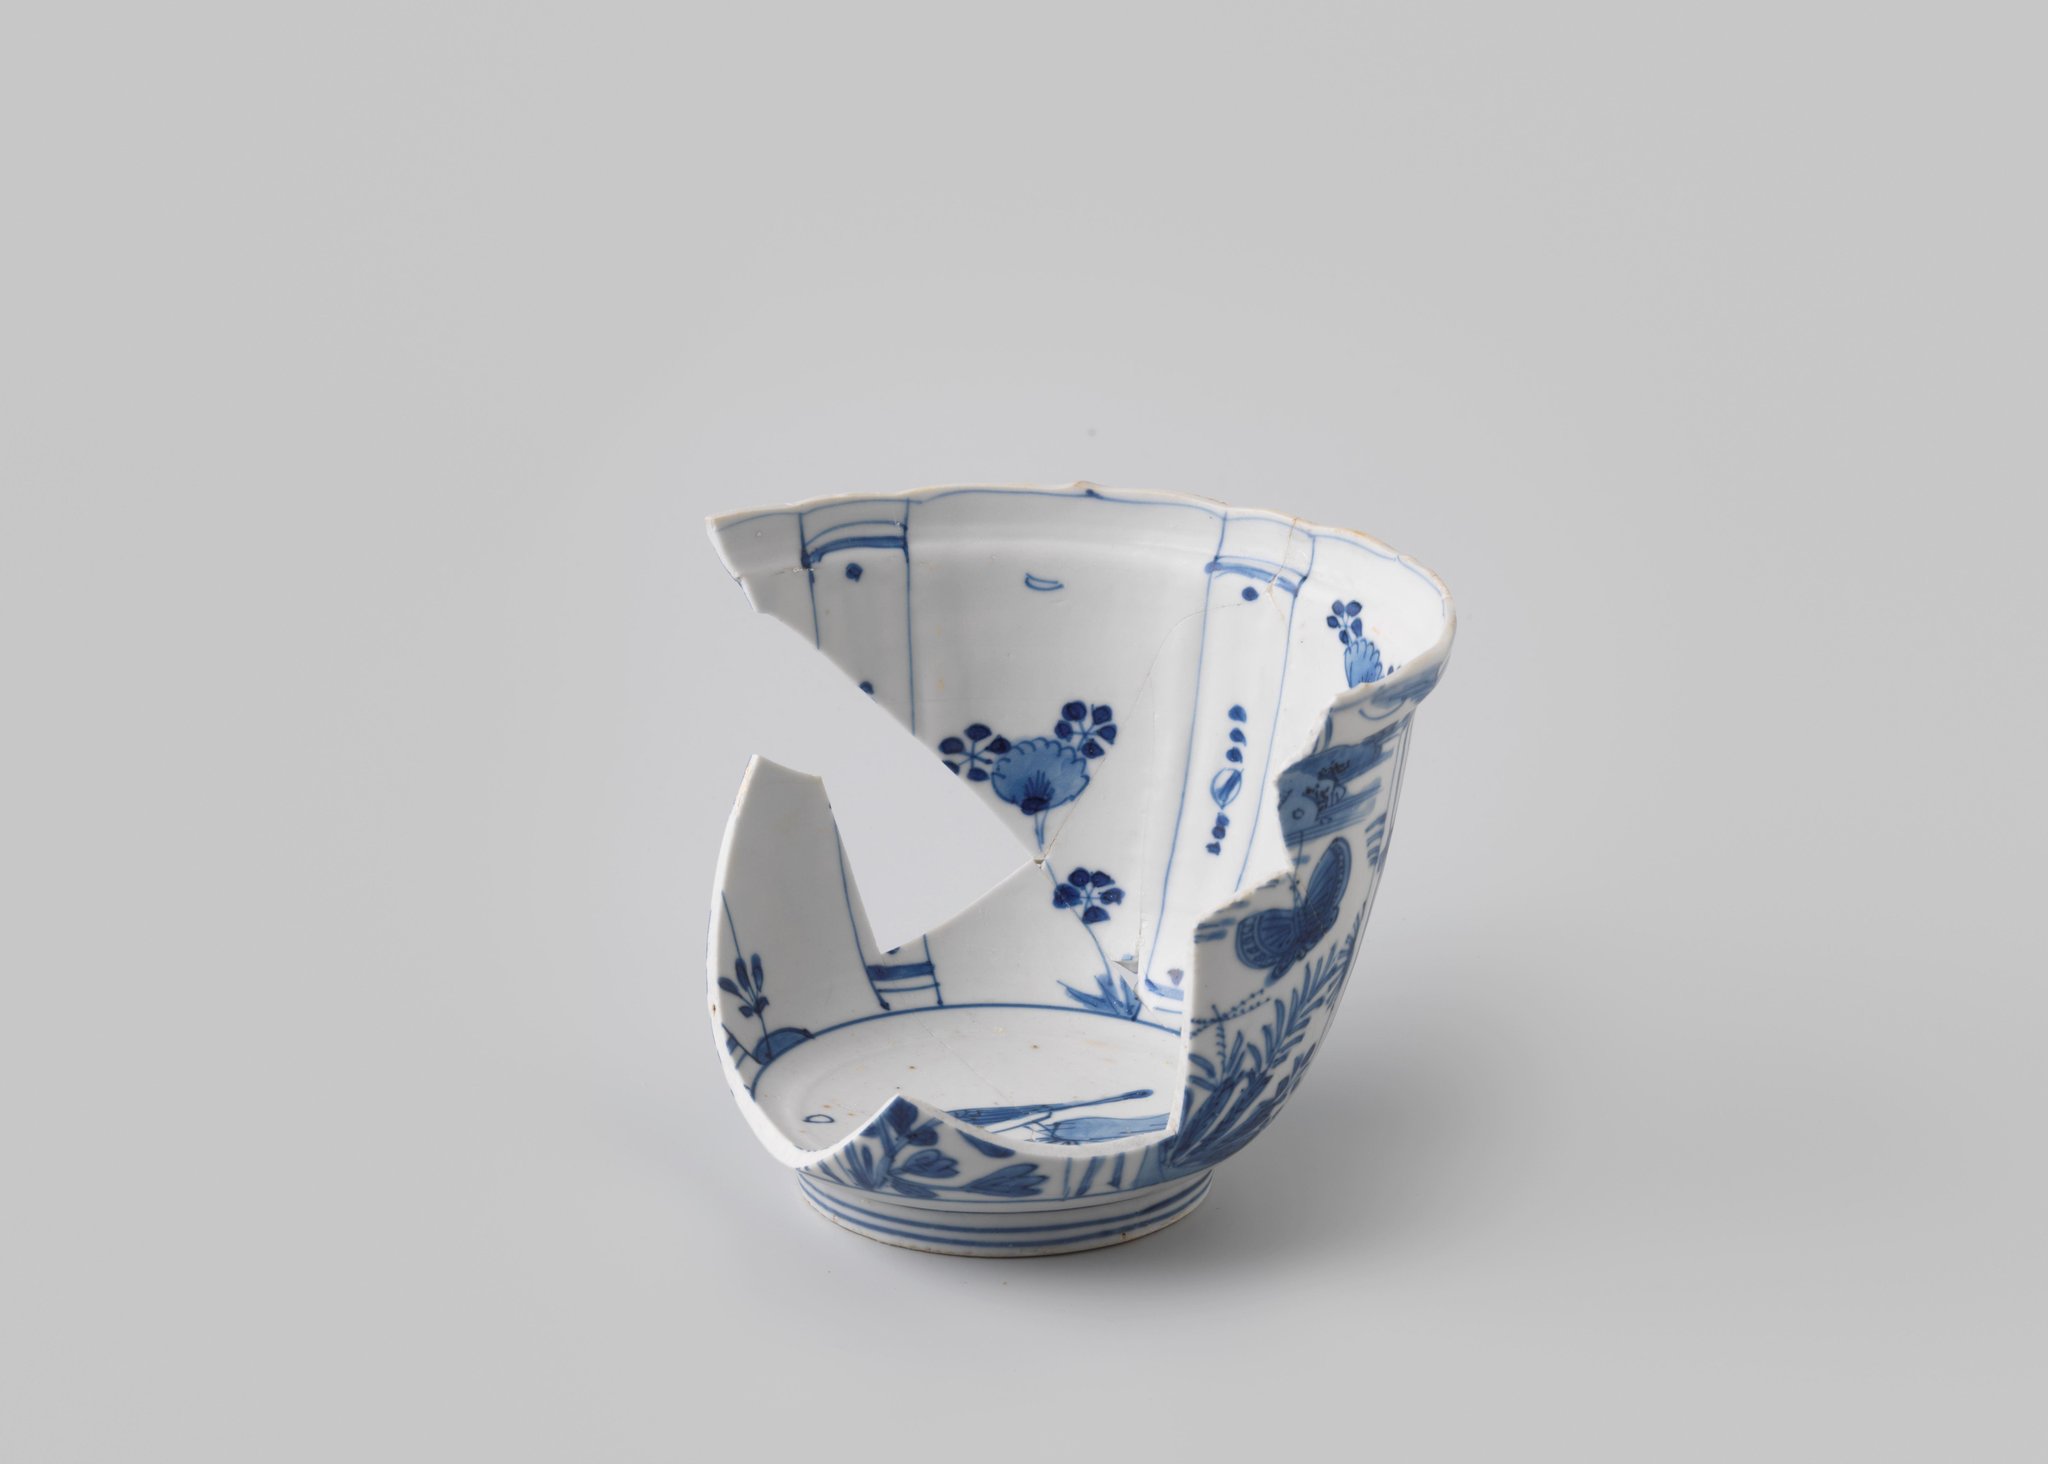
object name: bowl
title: Kraaikop uit V.O.C.-schip de 'Witte Leeuw'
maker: Anonymous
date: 1613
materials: bone china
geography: jingdezhen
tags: verenigde oostindische compagnie, sint-helena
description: A high bowl. The inside decorated with flower- and fruit-sprays. The exterior with flowers, a cicada and birds.